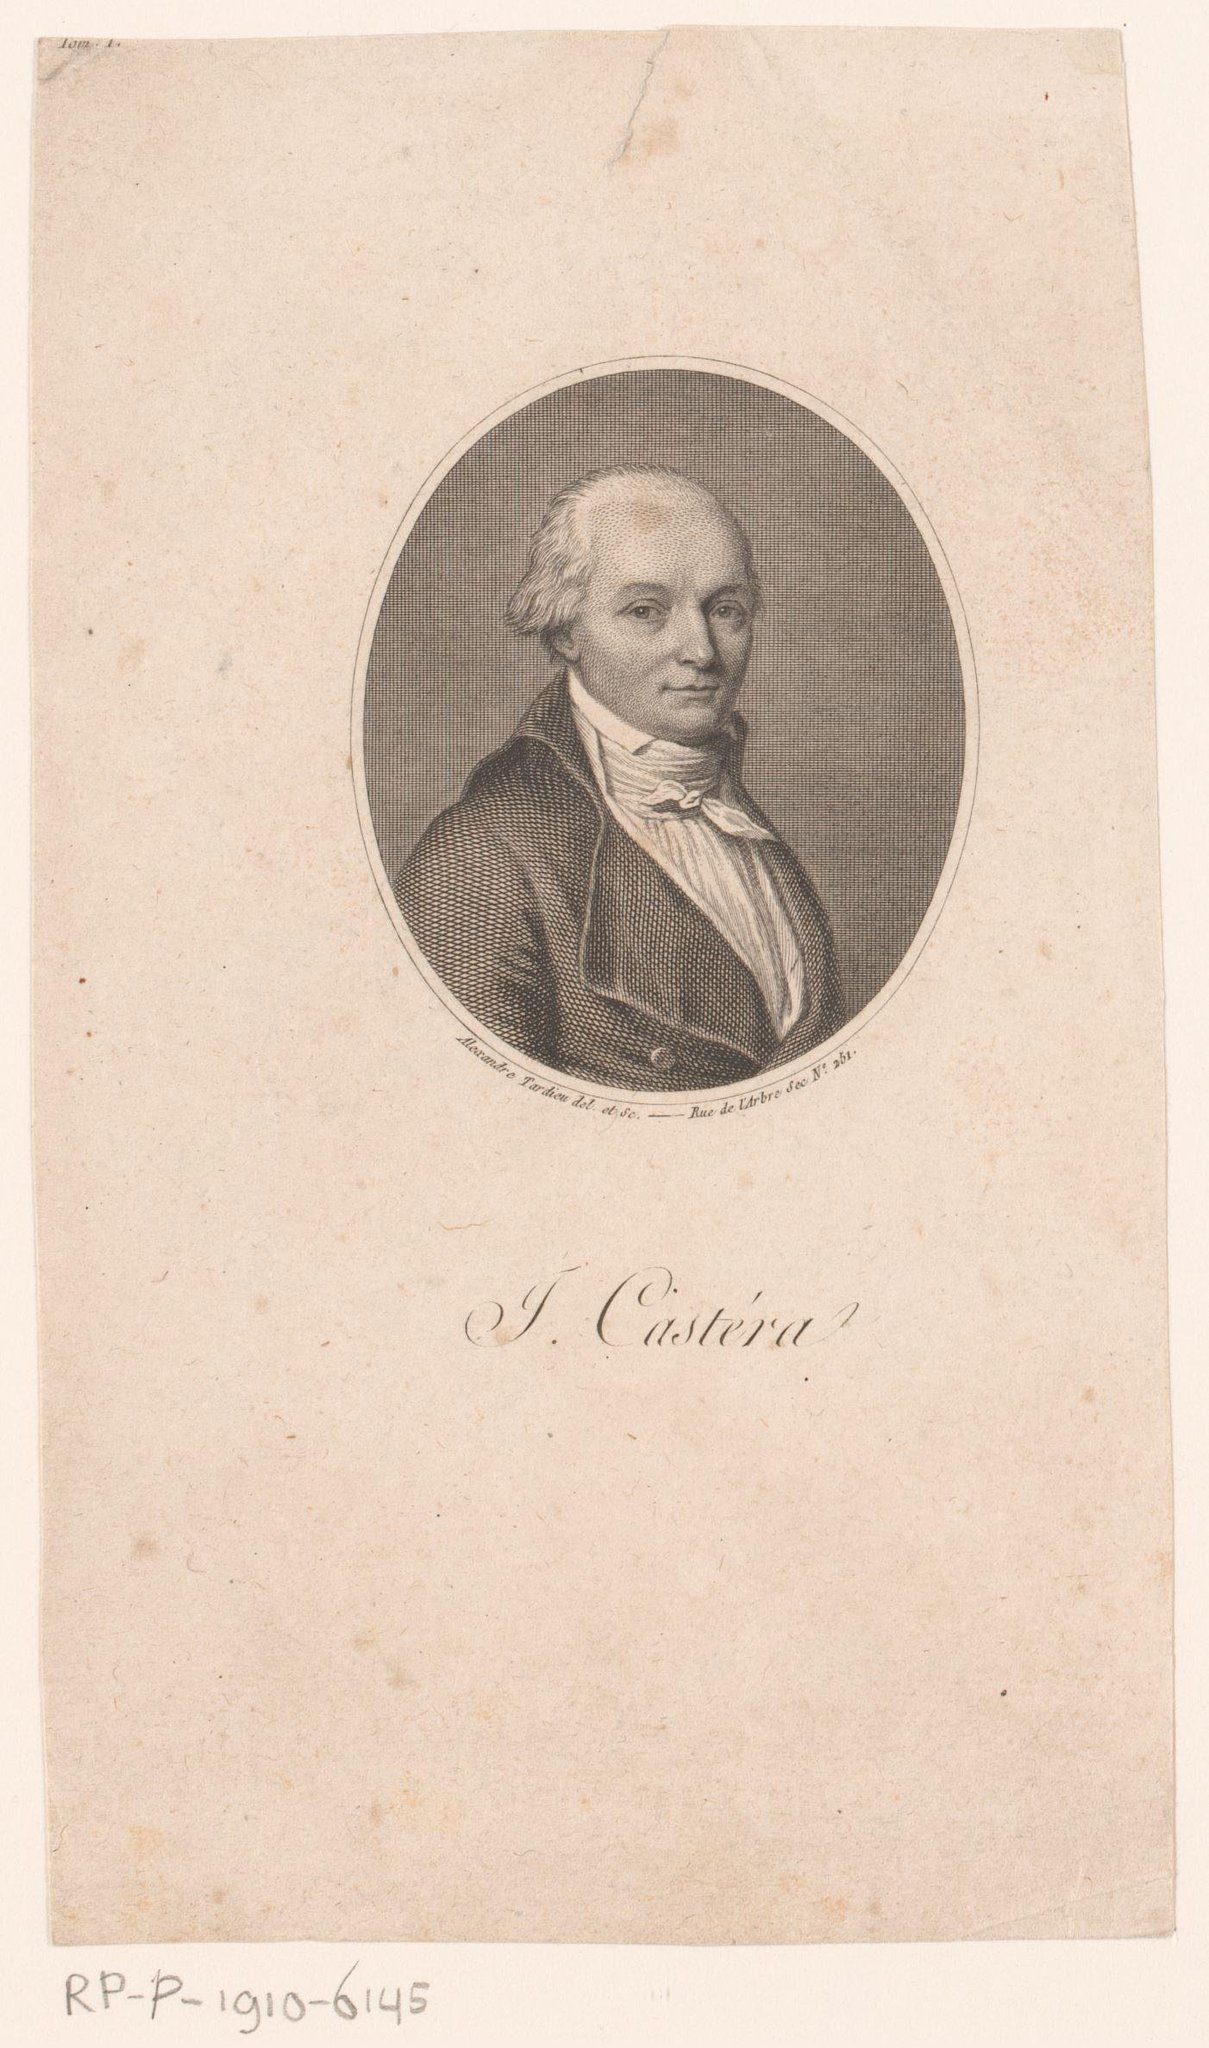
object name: print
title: Portret van J. Castéra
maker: alexandre tardieu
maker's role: print maker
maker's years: 1756-1844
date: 1766-1844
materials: paper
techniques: engraving, etching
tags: historical persons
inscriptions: collector's mark: Lugt 2228